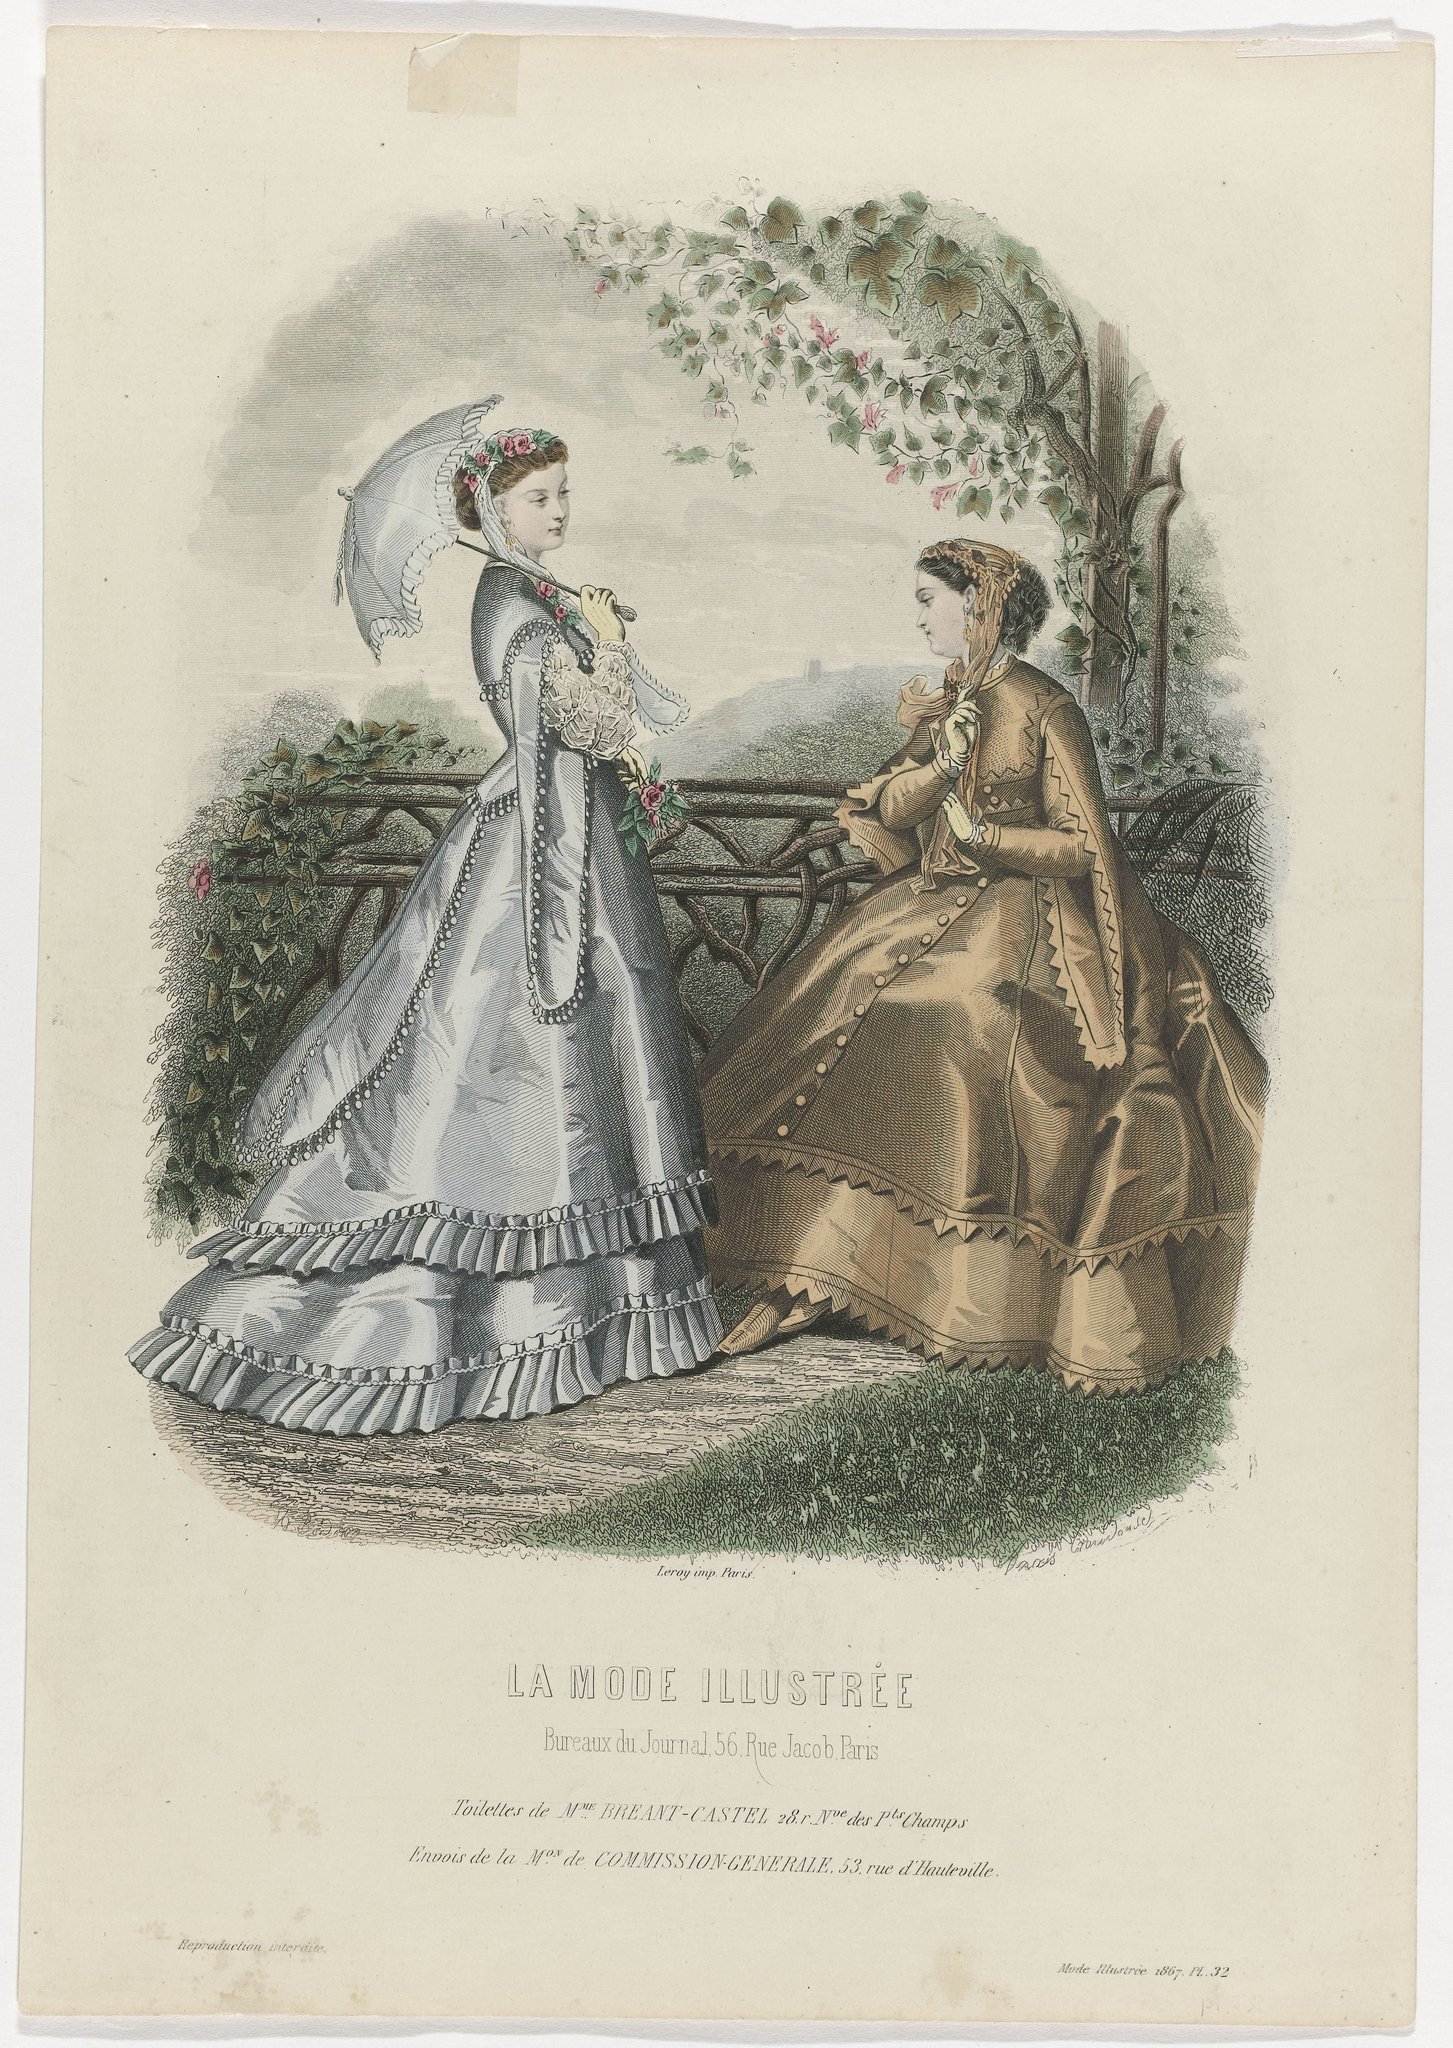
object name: fashion print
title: La Mode Illustrée, 1867, No. 32: Toilettes de Mme Breant-Castel (...)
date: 1867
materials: paper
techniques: hand coloring, engraving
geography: paris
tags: flowers, ear-rings (+ women's clothes), fashion plates, head-gear: hat (+ women's clothes), shoes, sandals (+ women's clothes), gloves, mittens, etc. (+ women's clothes), sleeves (+ women's clothes)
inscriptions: address: ‘Bureaux du Journal, 56, Rue Jacob. Paris’, caption: ‘Toilettes de M.me Breant-Castel 28.r. N.ve des P.ts Champs Envois de la M.on de Commission-generale. 53. rue d'Hauteville.’, title: ‘La Mode Illustrée’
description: Twee vrouwen, van wie één met parasol, op een bordes. De zittende vrouw draagt een japon met losse siermouwen. Volgens het onderschrift: ensembles van Breant-Castel. Prent uit het modetijdschrift La Mode Illustrée (1860-1937).